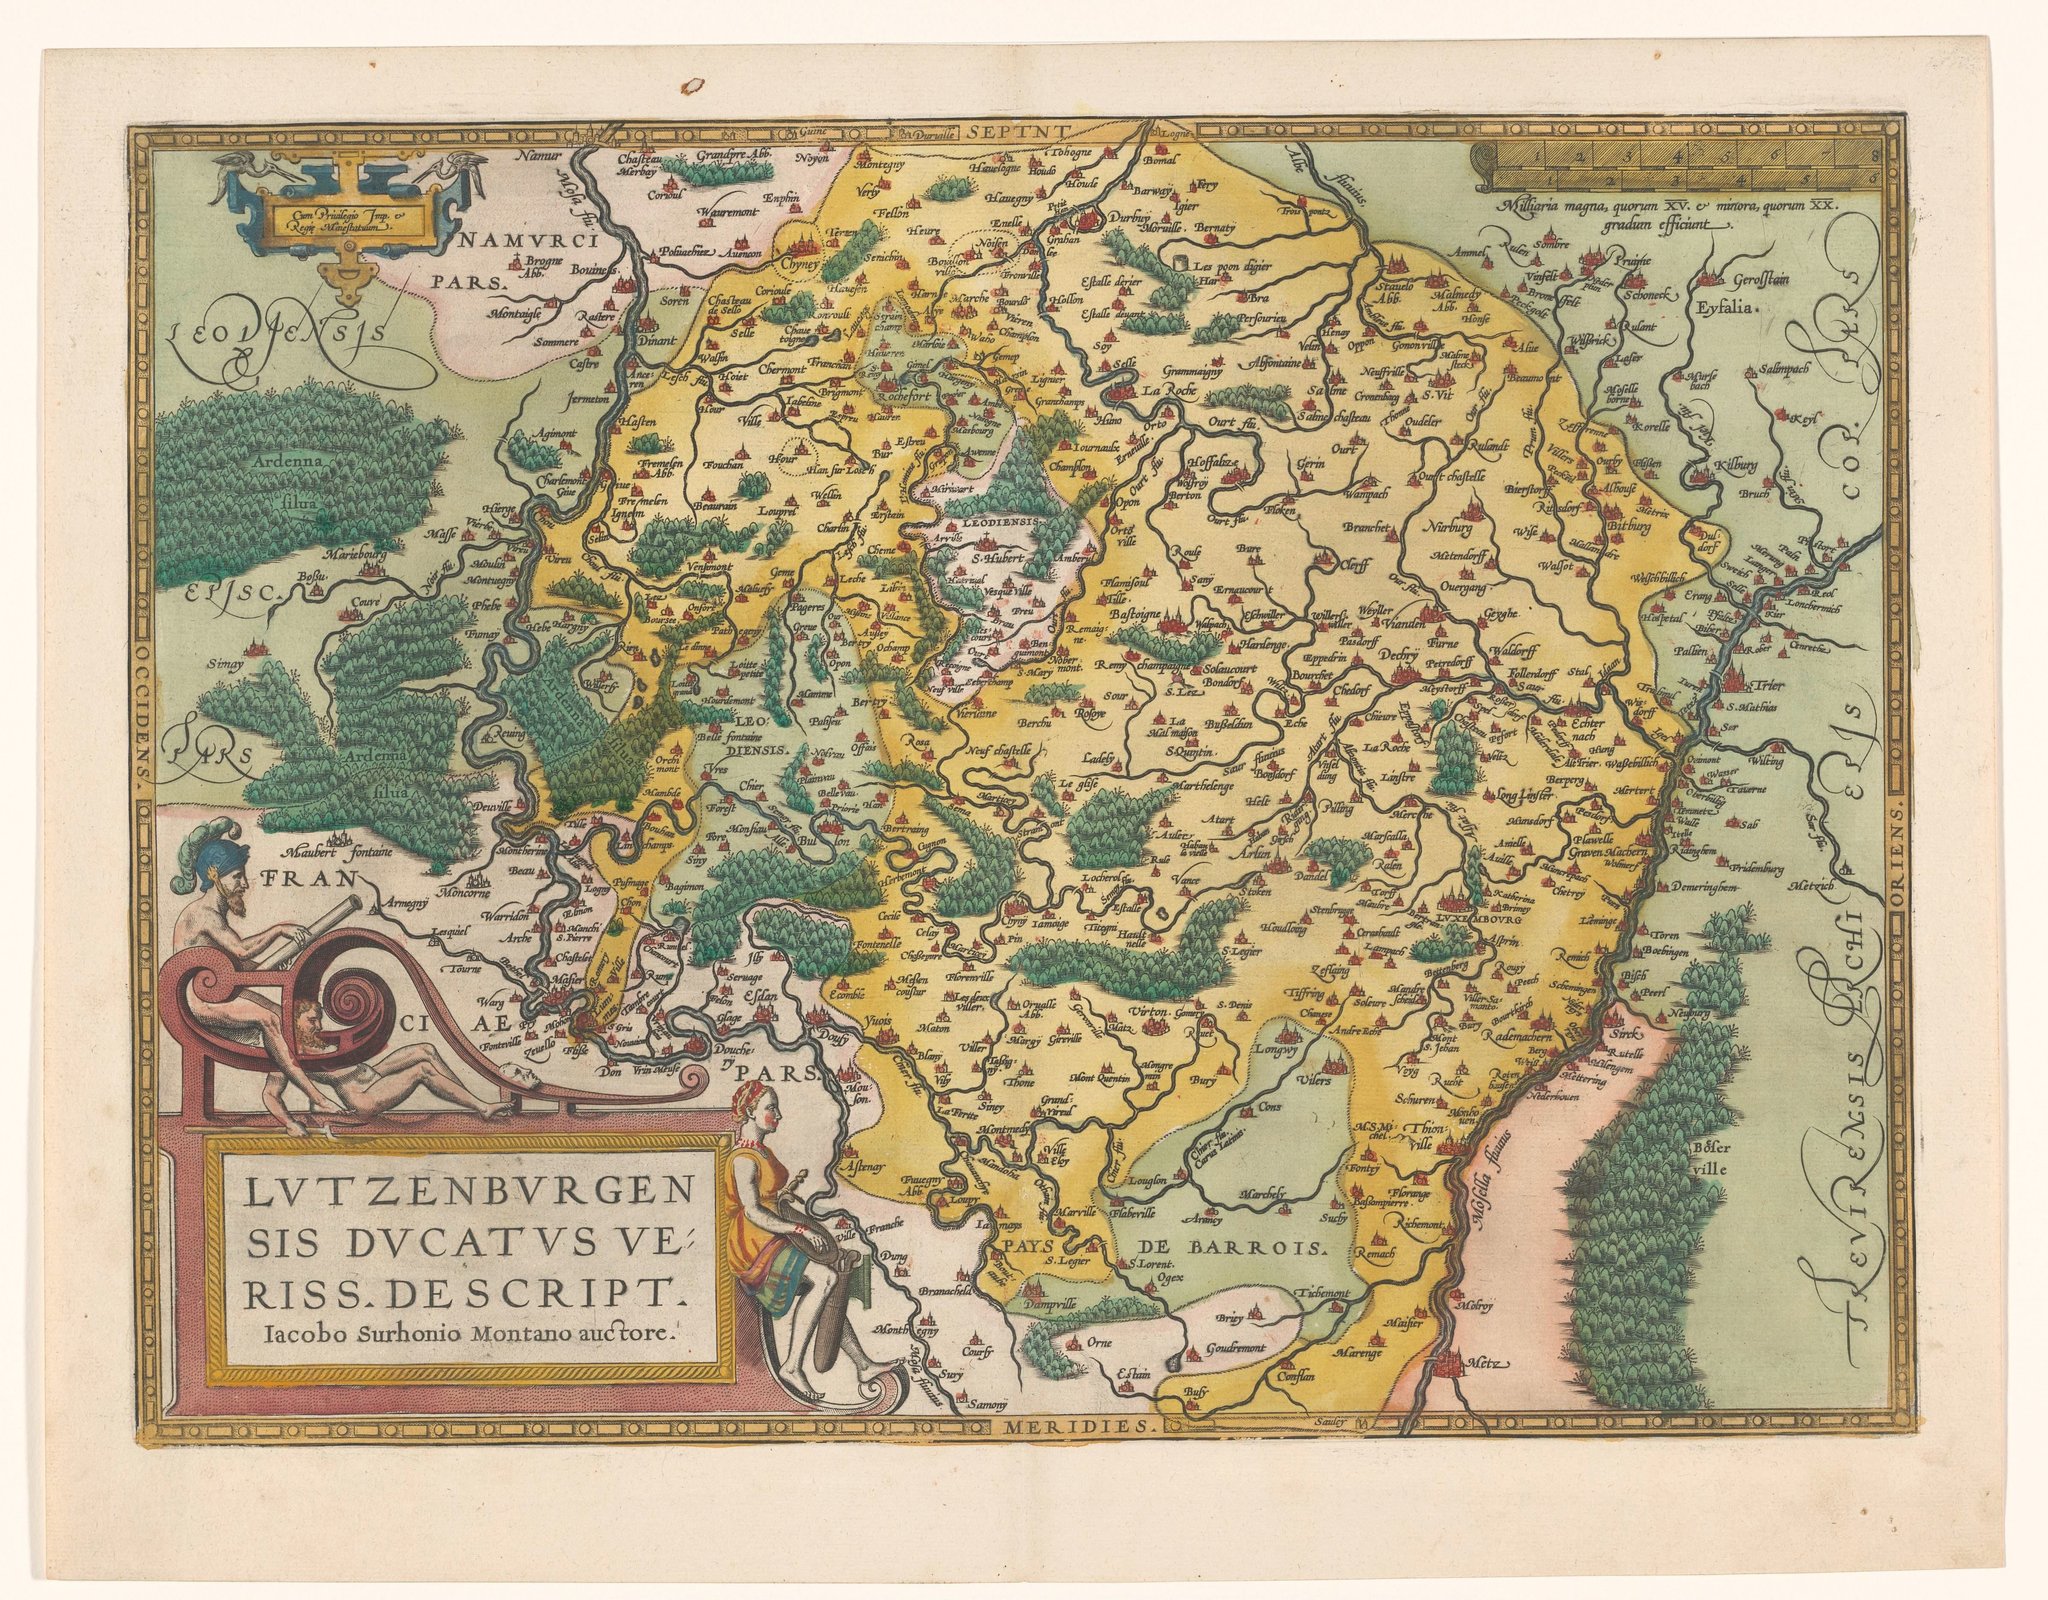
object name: map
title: Lutzenburgensis ducatus veriss. descript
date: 1592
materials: paper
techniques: engraving, hand coloring, letterpress printing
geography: antwerp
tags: maps of separate countries or regions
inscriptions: collector's mark: Lugt 2228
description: Kaart van het hertogdom Luxemburg. Linksonder de titelcartouche. Rechtsboven een cartouche met twee schaalstokken. Linksboven een cartouche met privilege. Met Latijnse tekst op verso.